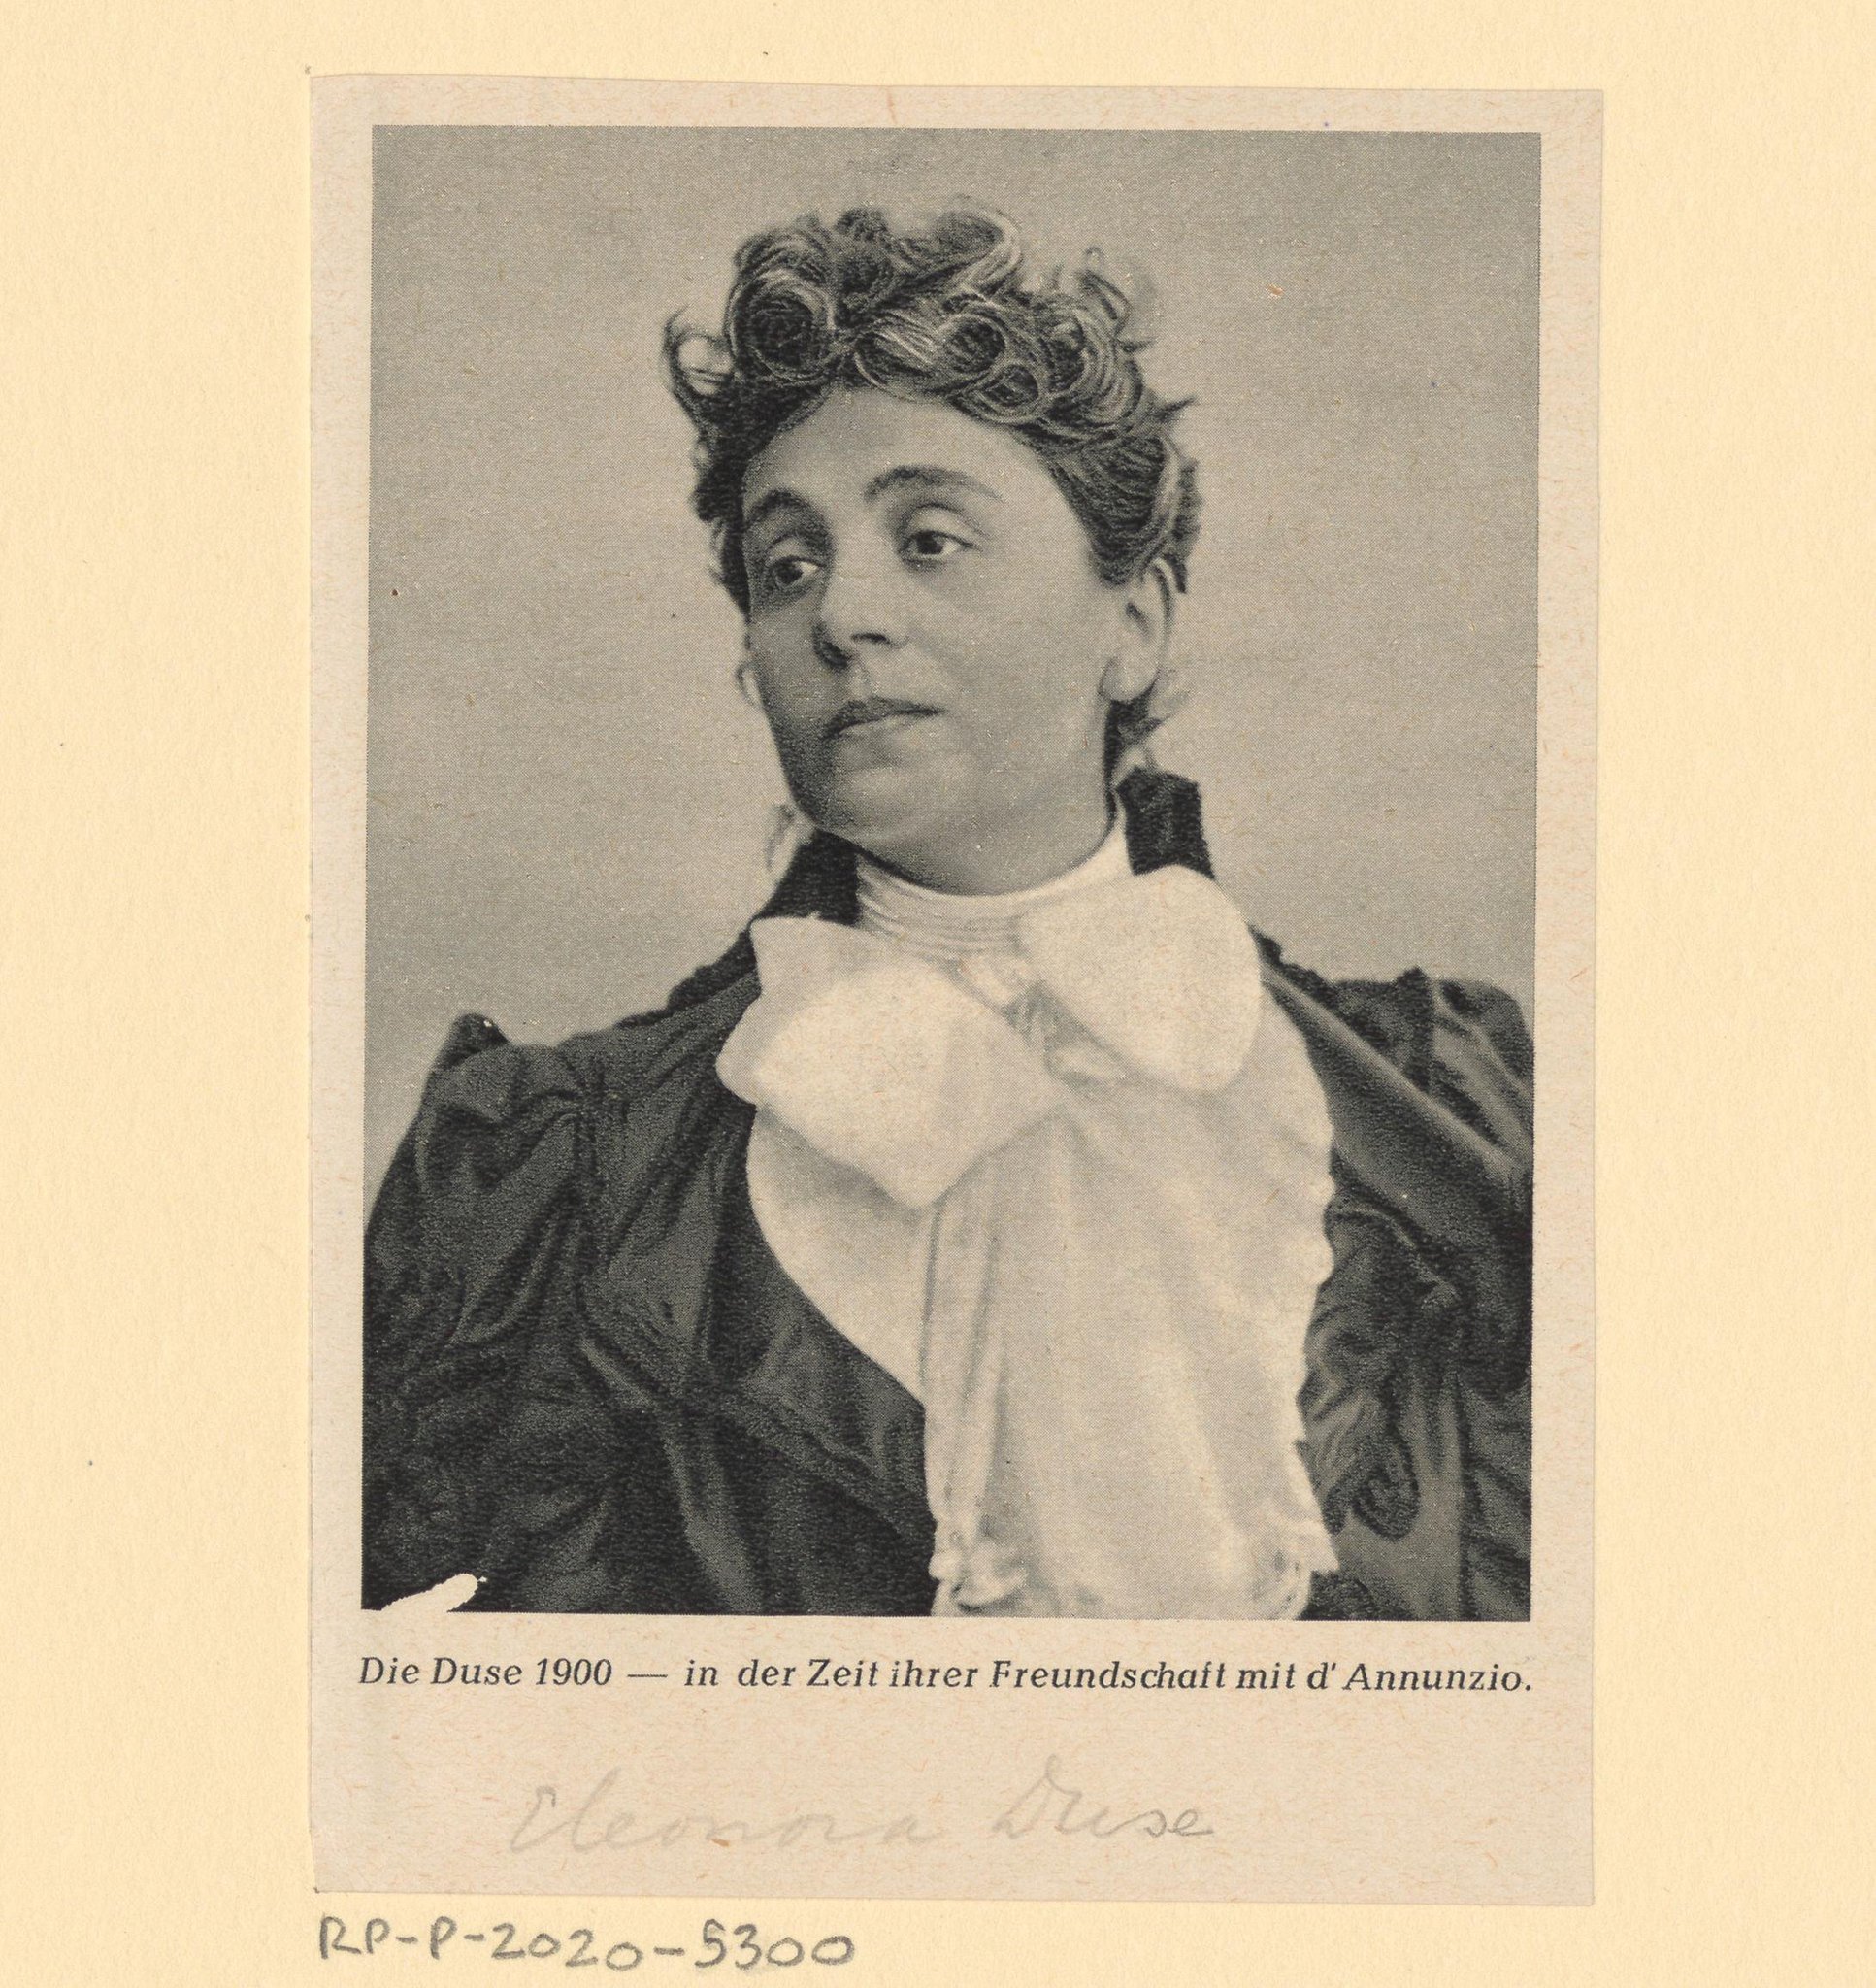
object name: photomechanical print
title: Portret van Eleonora Duse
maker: Anonymous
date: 1900-1950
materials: paper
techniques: rotogravure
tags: historical persons - bb - woman, actor (on the stage)